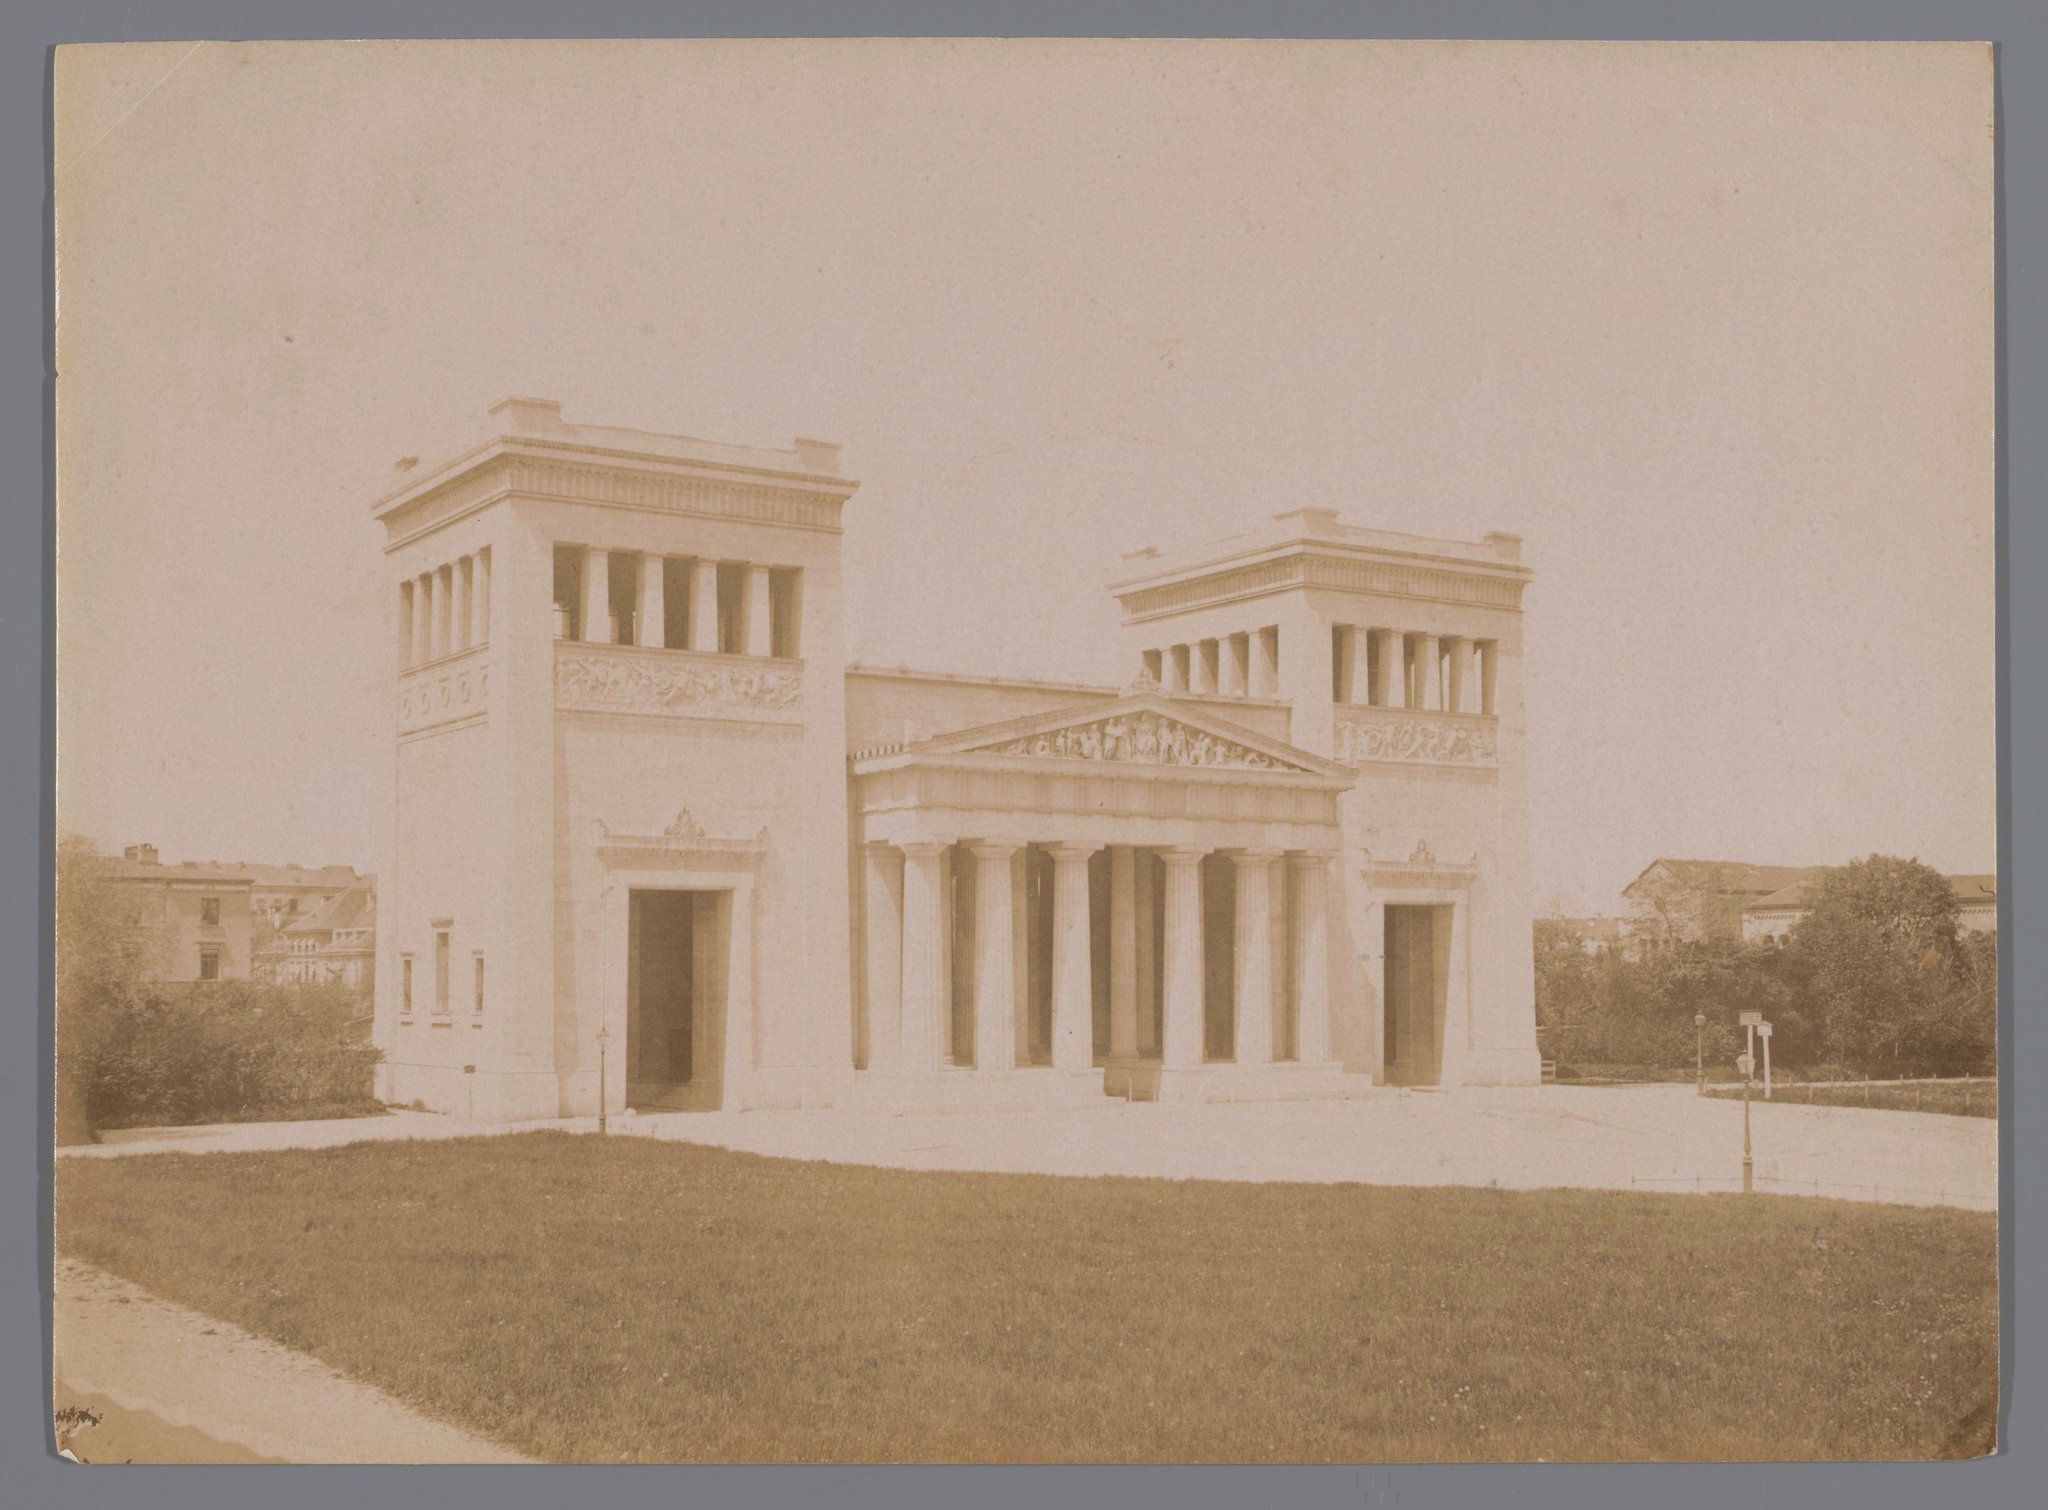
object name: photograph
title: Propyleeënpoort te München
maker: Anonymous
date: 1870-1900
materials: paper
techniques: albumen print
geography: munich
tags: gate, entrance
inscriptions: inscription: ‘München Propulaion’